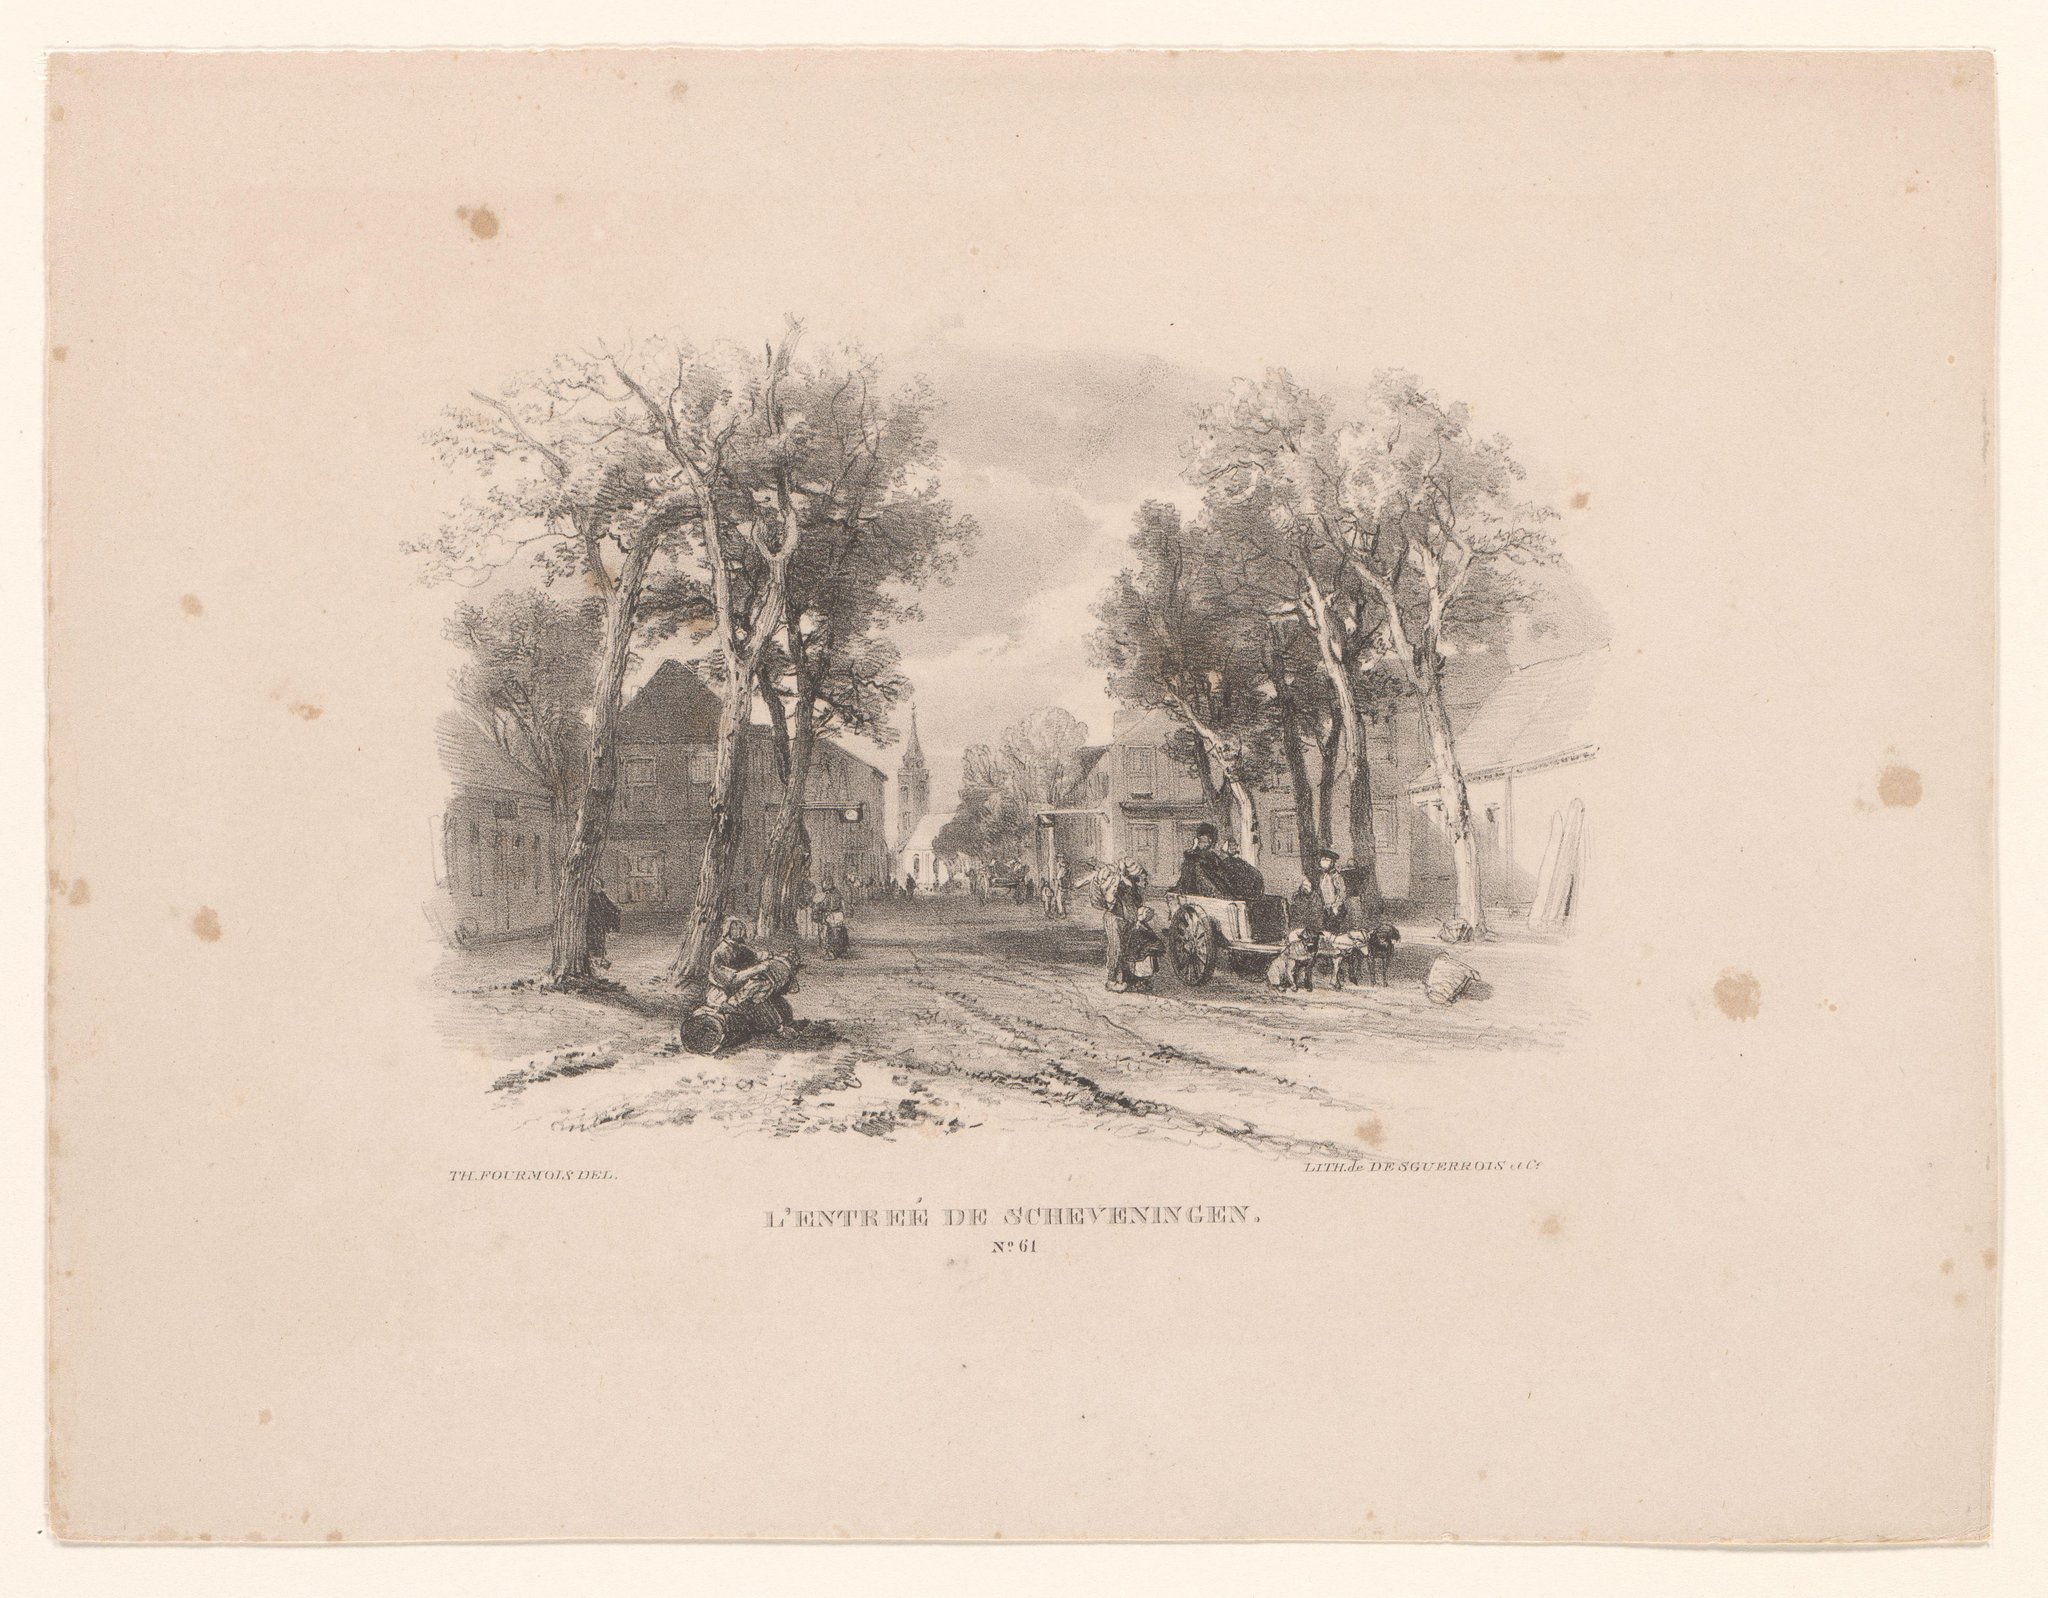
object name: print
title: Weg naar Scheveningen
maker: théodore fourmois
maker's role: print maker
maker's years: 1814-1871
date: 1827-1871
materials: paper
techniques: lithograph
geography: amsterdam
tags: two-wheeled, animal-drawn vehicle, city-view in general; 'veduta' (+ city(-scape) with figures, staffage), public road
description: Prent maakt deel uit van een serie met gezichten op Den Haag en Scheveningen. Over deze serie is verder niets bekend.